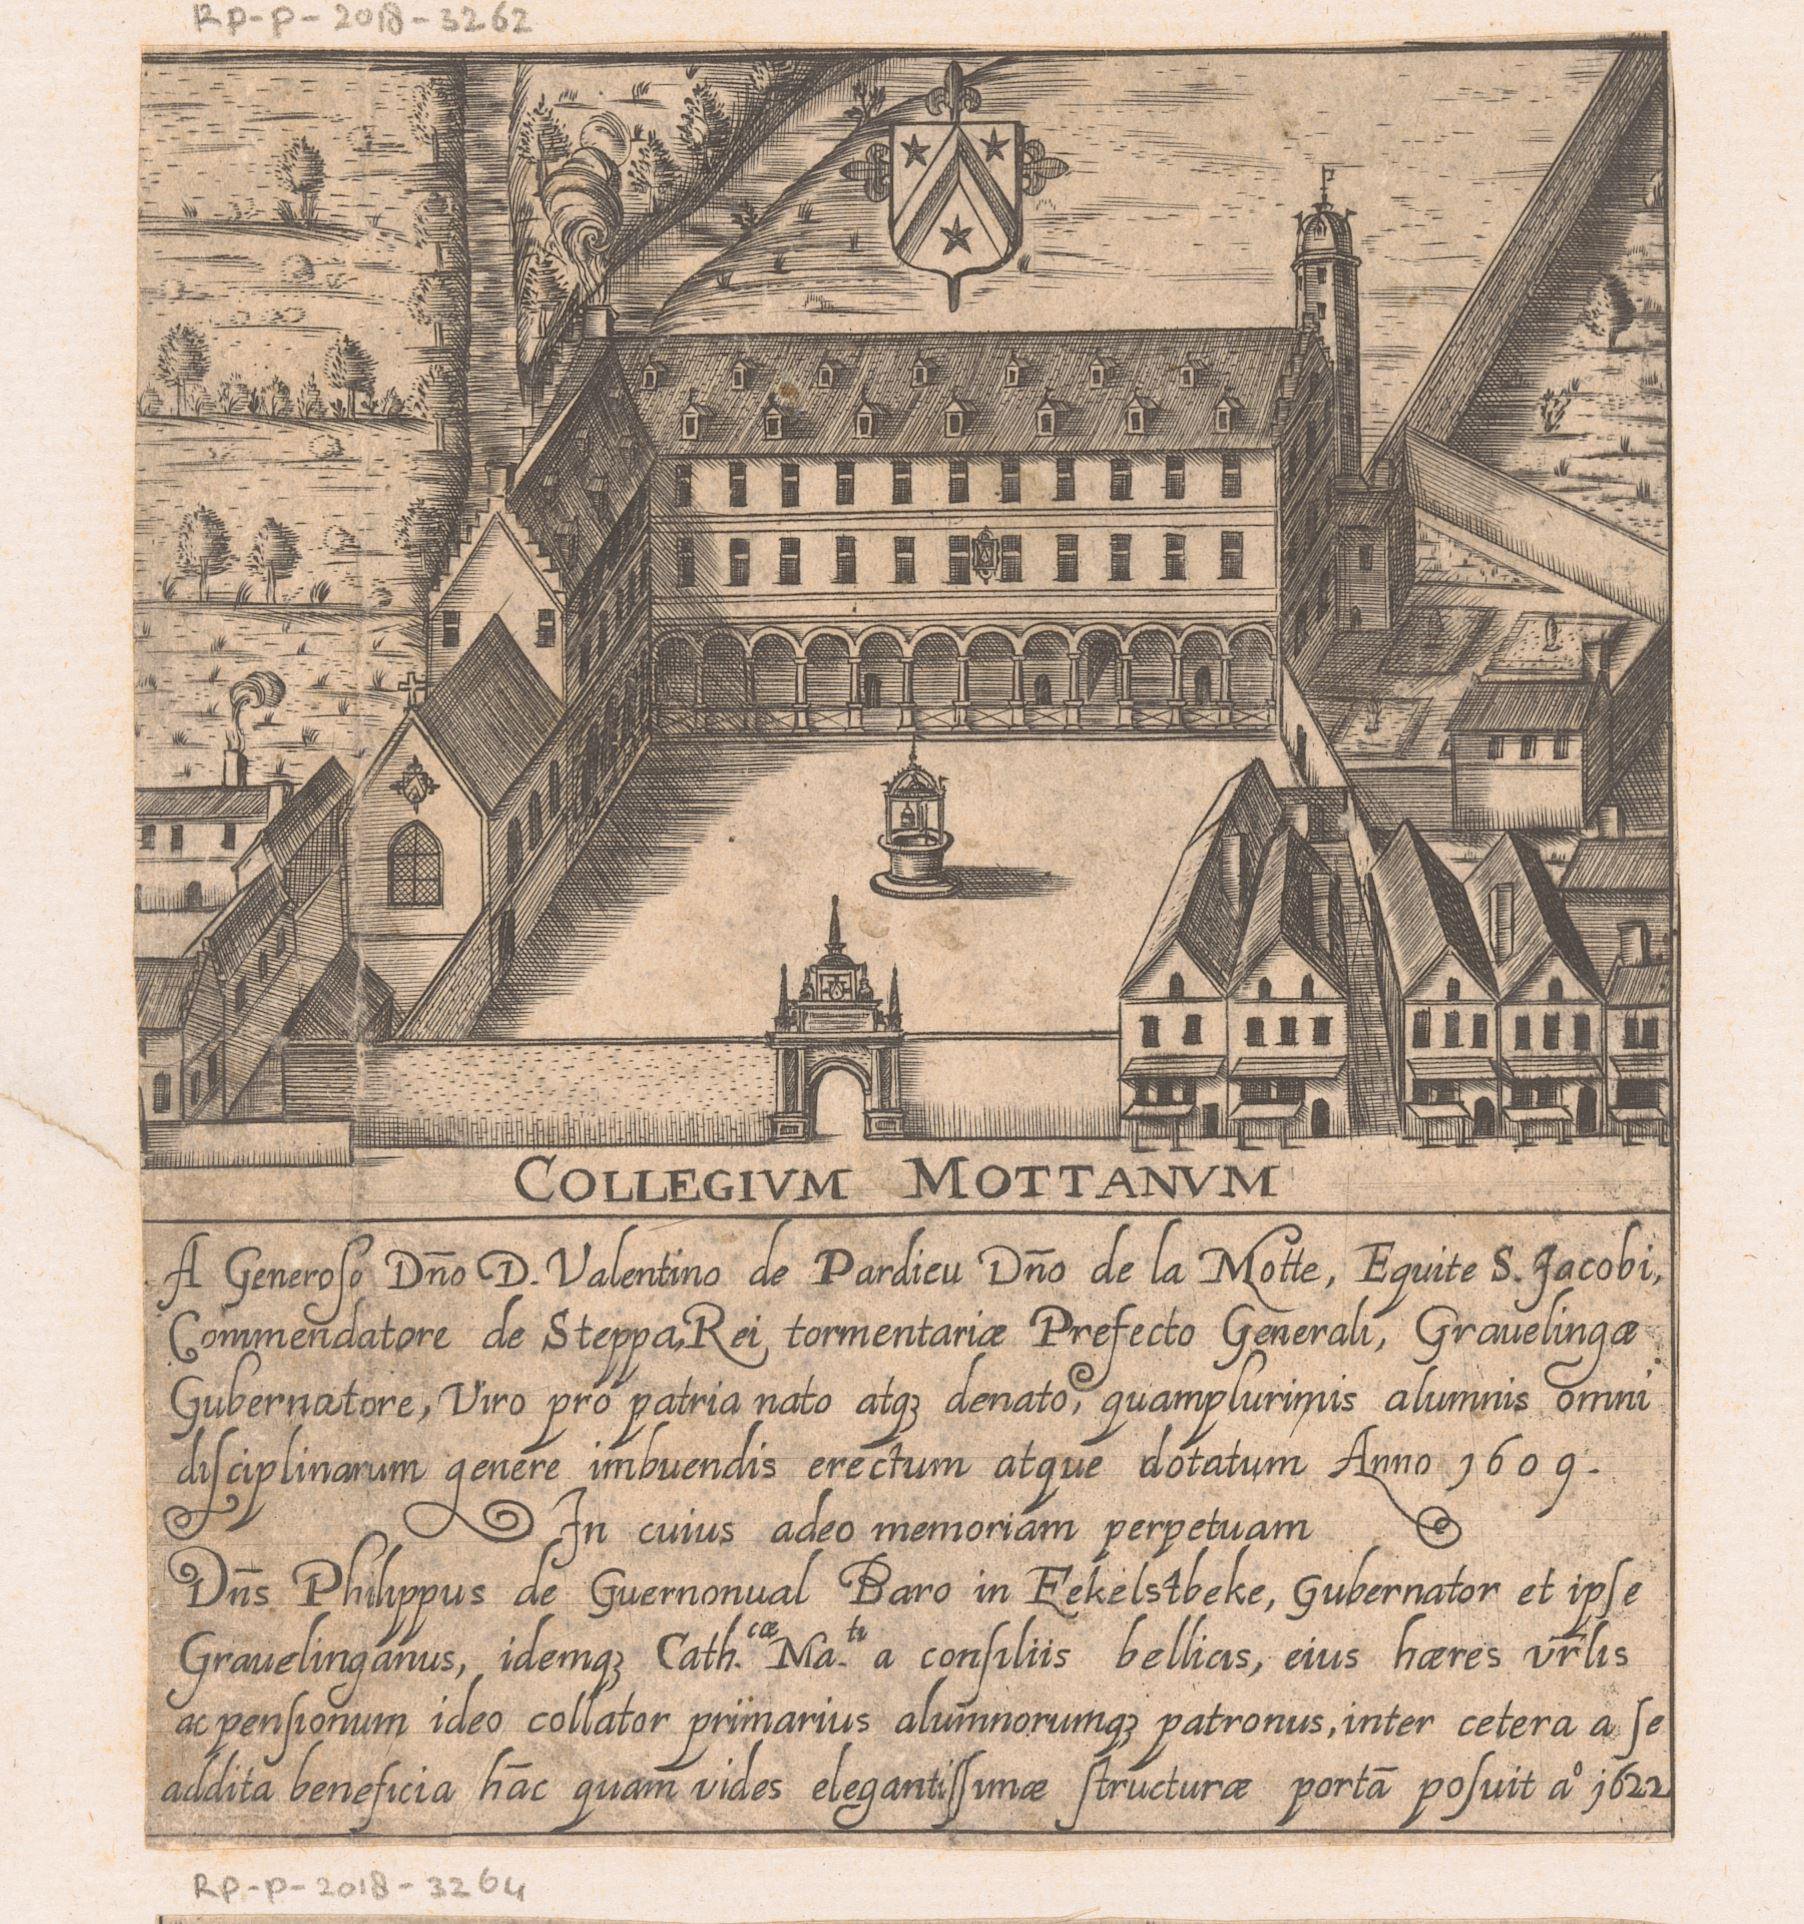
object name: print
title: Collegium Mottanum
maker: filippo ferrari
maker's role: print maker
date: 1605-1680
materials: paper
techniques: etching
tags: university building, college, prospect of city, town panorama, silhouette of city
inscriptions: collector's mark: Lugt 2228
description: Onderdeel van een reeks gezichten op steden/gebouwen met bijbehorend voorblad met tekst en legenda. De legendanummers zijn naast de afbeeldingen bijgeschreven. De afbeeldingen zijn per zes op één blad bevestigd.